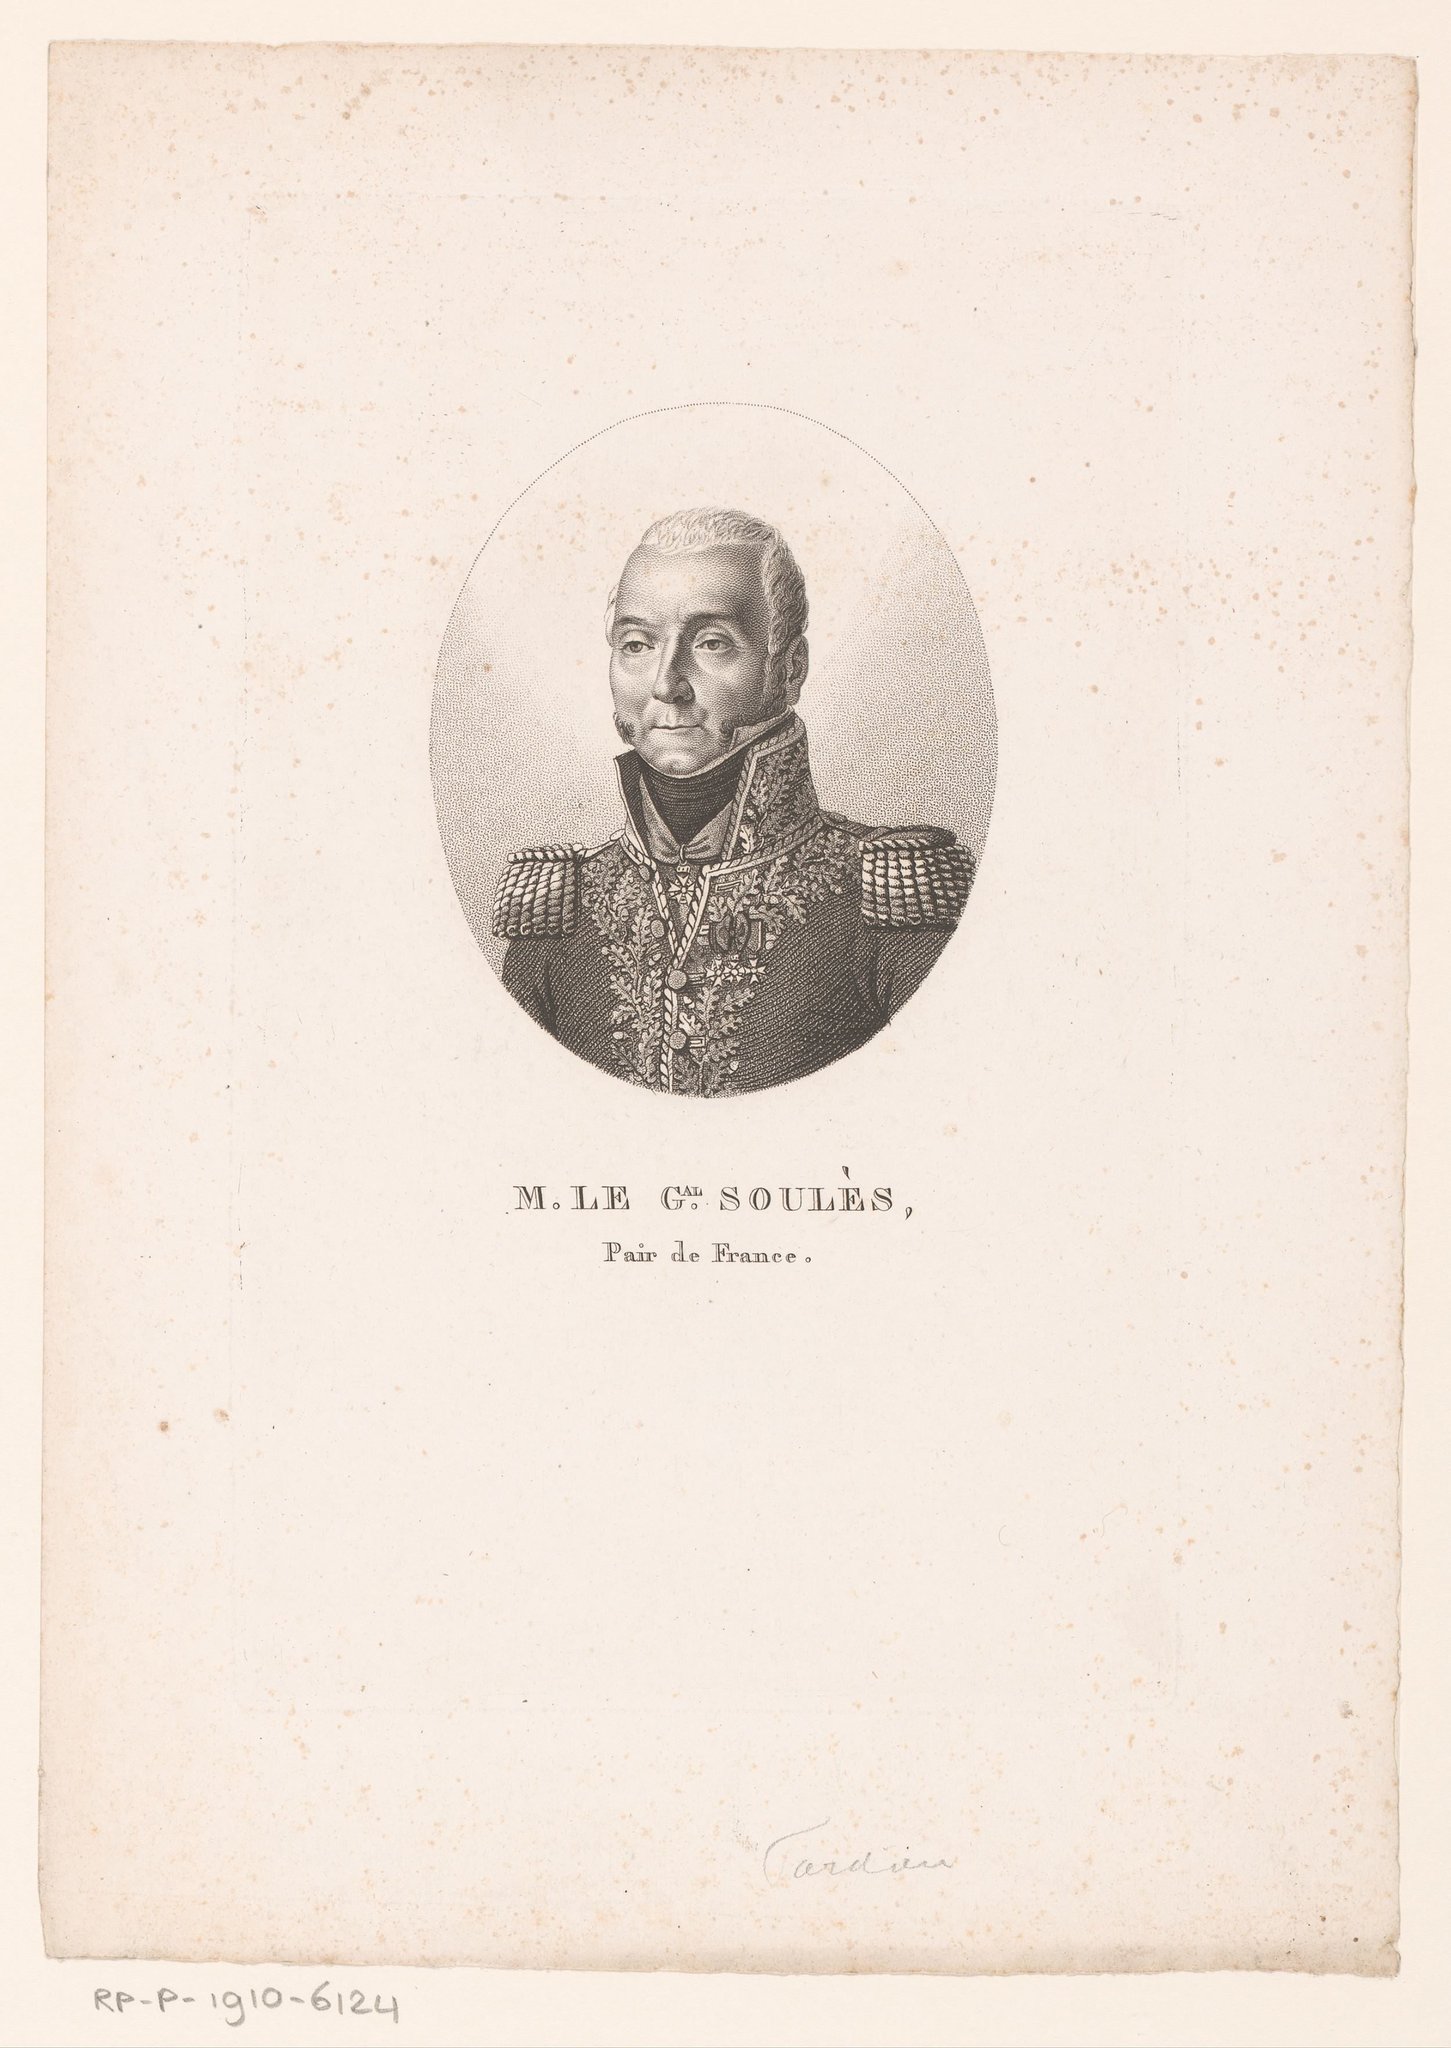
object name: book illustration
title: Portret van Jérôme Soulès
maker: ambroise tardieu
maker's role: print maker, printer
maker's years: 1788-1841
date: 1820-1821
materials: paper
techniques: engraving, roulette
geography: paris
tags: politician, historical persons, politician, e.g. party leader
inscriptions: collector's mark: Lugt 2228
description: Prent uit: Tardieu, Ambroise. Portraits des députés, écrivains et pairs constitutionnels, défenseurs invariables de la charte et de la loi des élections du 5 février 1817. Parijs: Tardieu, Ambroise, 1820-1821.